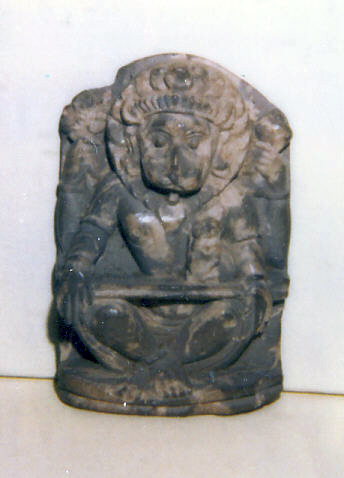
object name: figure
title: Seated Narasimha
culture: kashmiri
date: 601-900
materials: stone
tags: kashmir